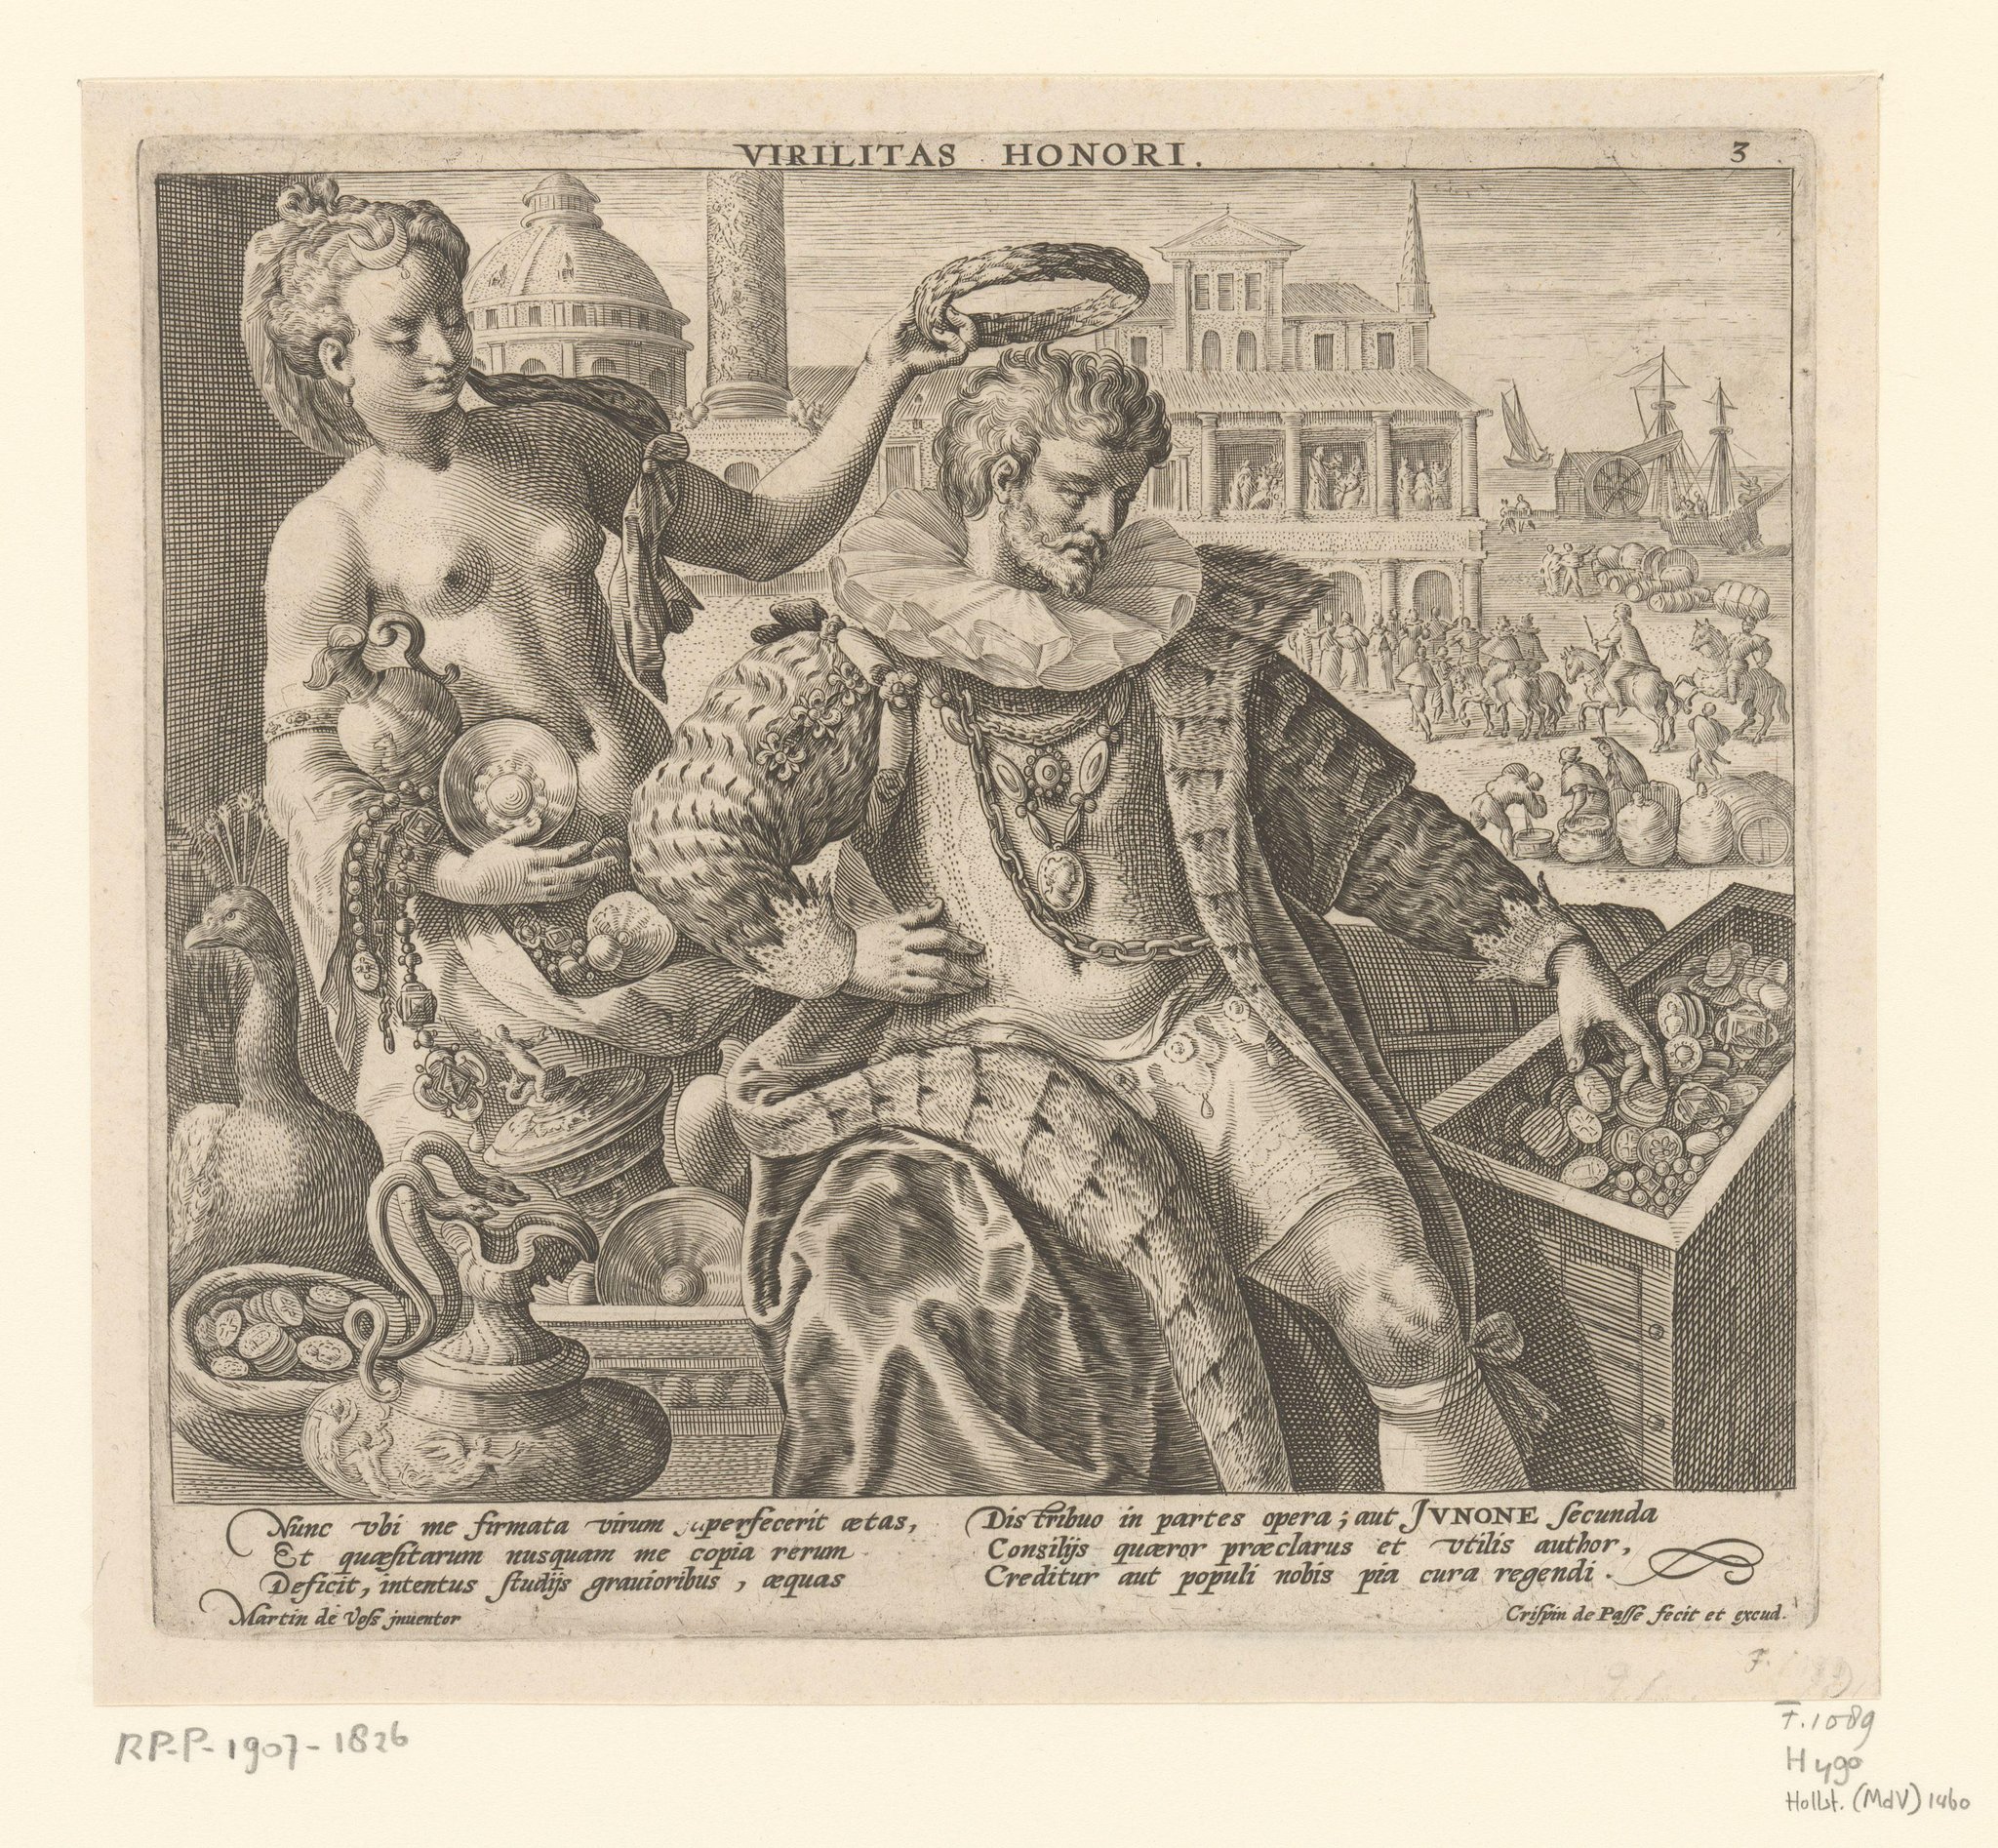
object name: print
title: Volwassenheid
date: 1596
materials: paper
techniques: engraving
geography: cologne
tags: adulthood, majority; 'virilità' (ripa), (story of) juno (hera)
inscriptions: collector's mark: Lugt 2228, collector's mark: Lugt 1337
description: Een rijk geklede man zit te midden van kisten met geld en vazen. Hij wordt vergezeld door Juno die hem kroont met een lauwerkrans en sieraden en vazen vasthoudt. Op de achtergrond een haven. In de marge een zesregelig onderschrift, in twee kolommen, in het Latijn.